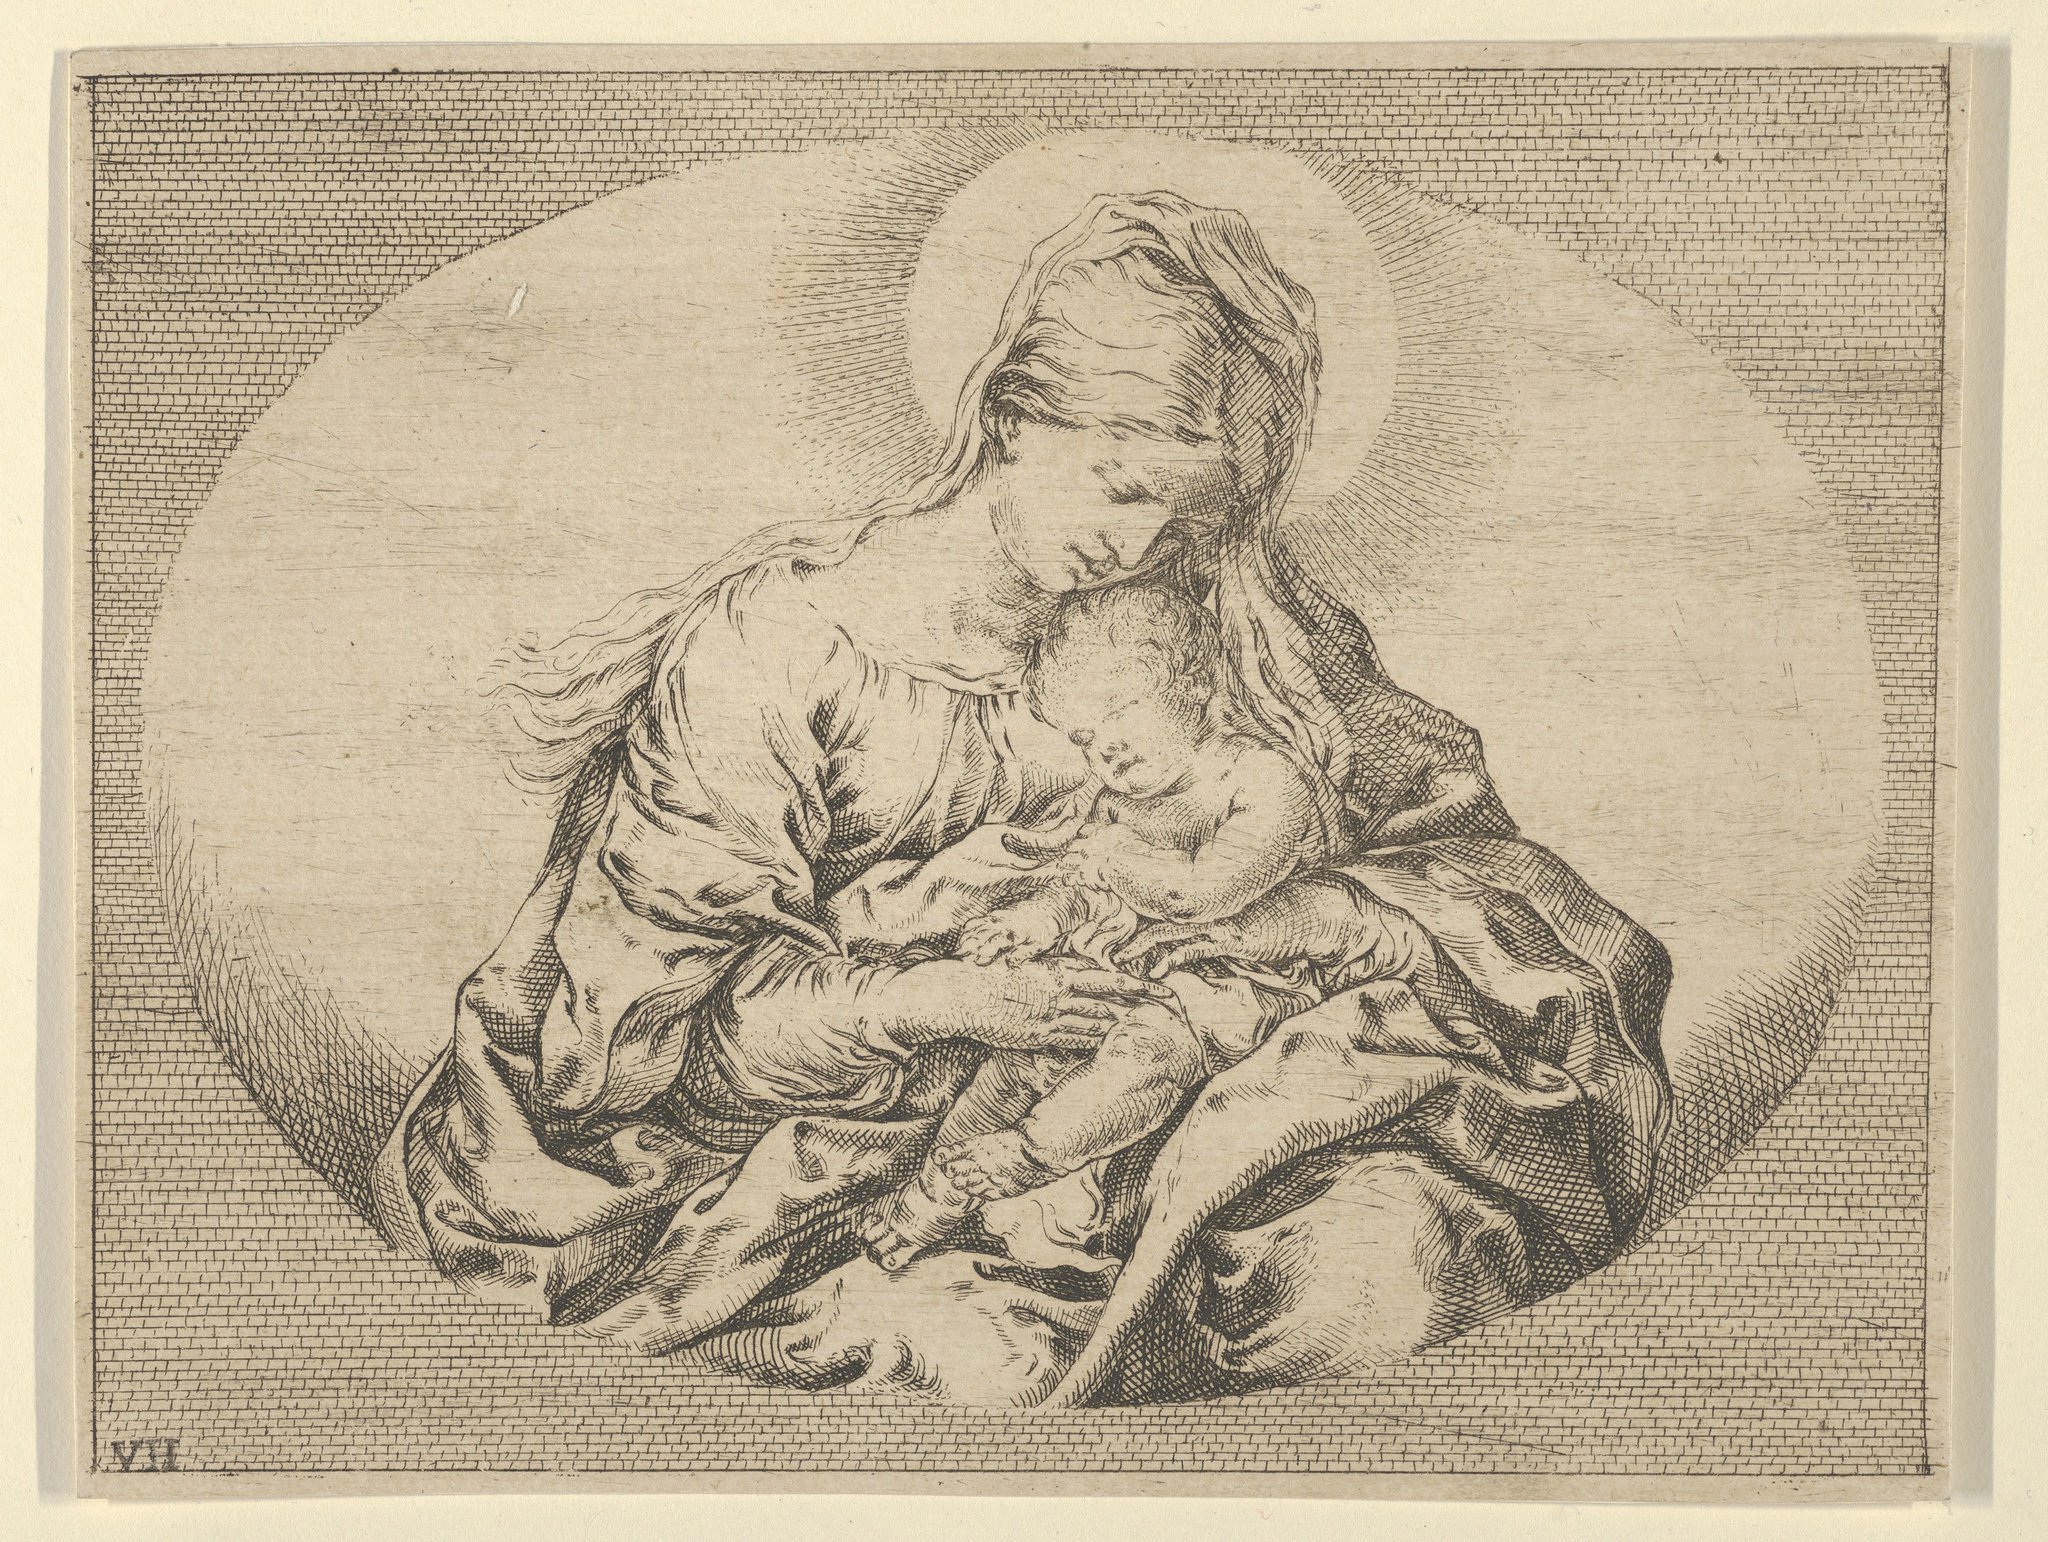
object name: print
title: The Virgin holding the infant Christ, an oval composition, after Reni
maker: anonymous, 17th century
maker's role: artist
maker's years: 1600-1700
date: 1600-1640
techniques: etching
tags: madonna and child